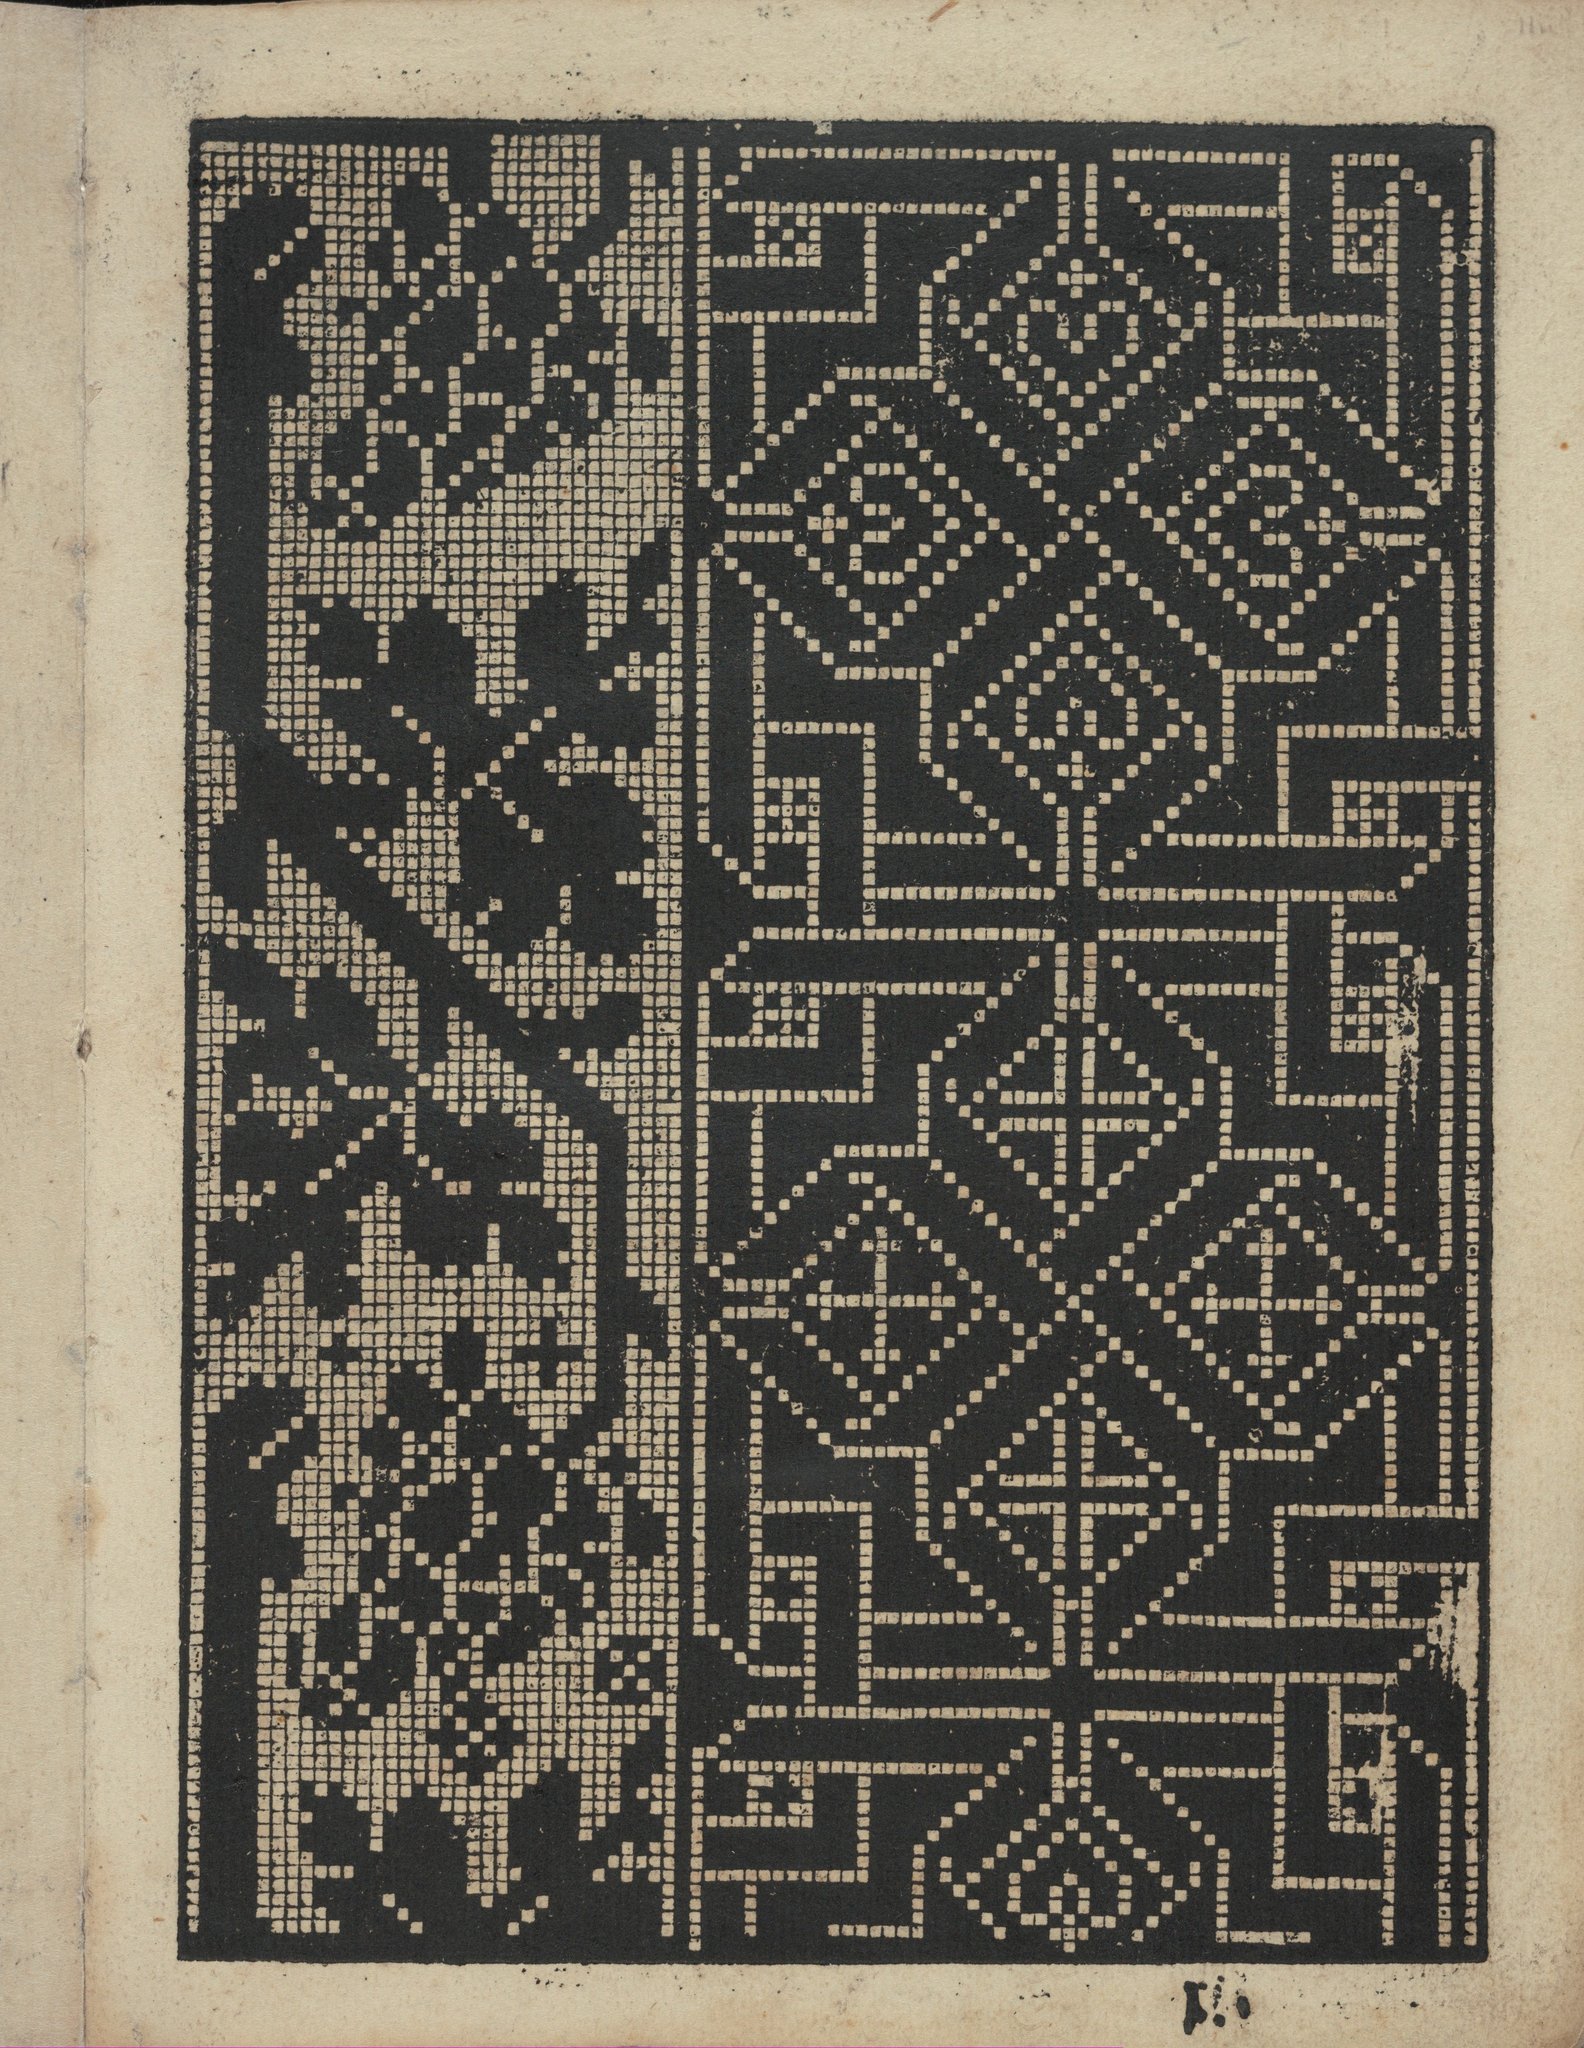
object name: book print ornament architecture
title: Libbretto nouellamete composto per maestro Domenico da Sera...lauorare di ogni sorte di punti, page 11 (recto)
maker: domenico da sera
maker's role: publisher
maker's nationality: french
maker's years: 1500-1599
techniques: woodcut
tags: ornament